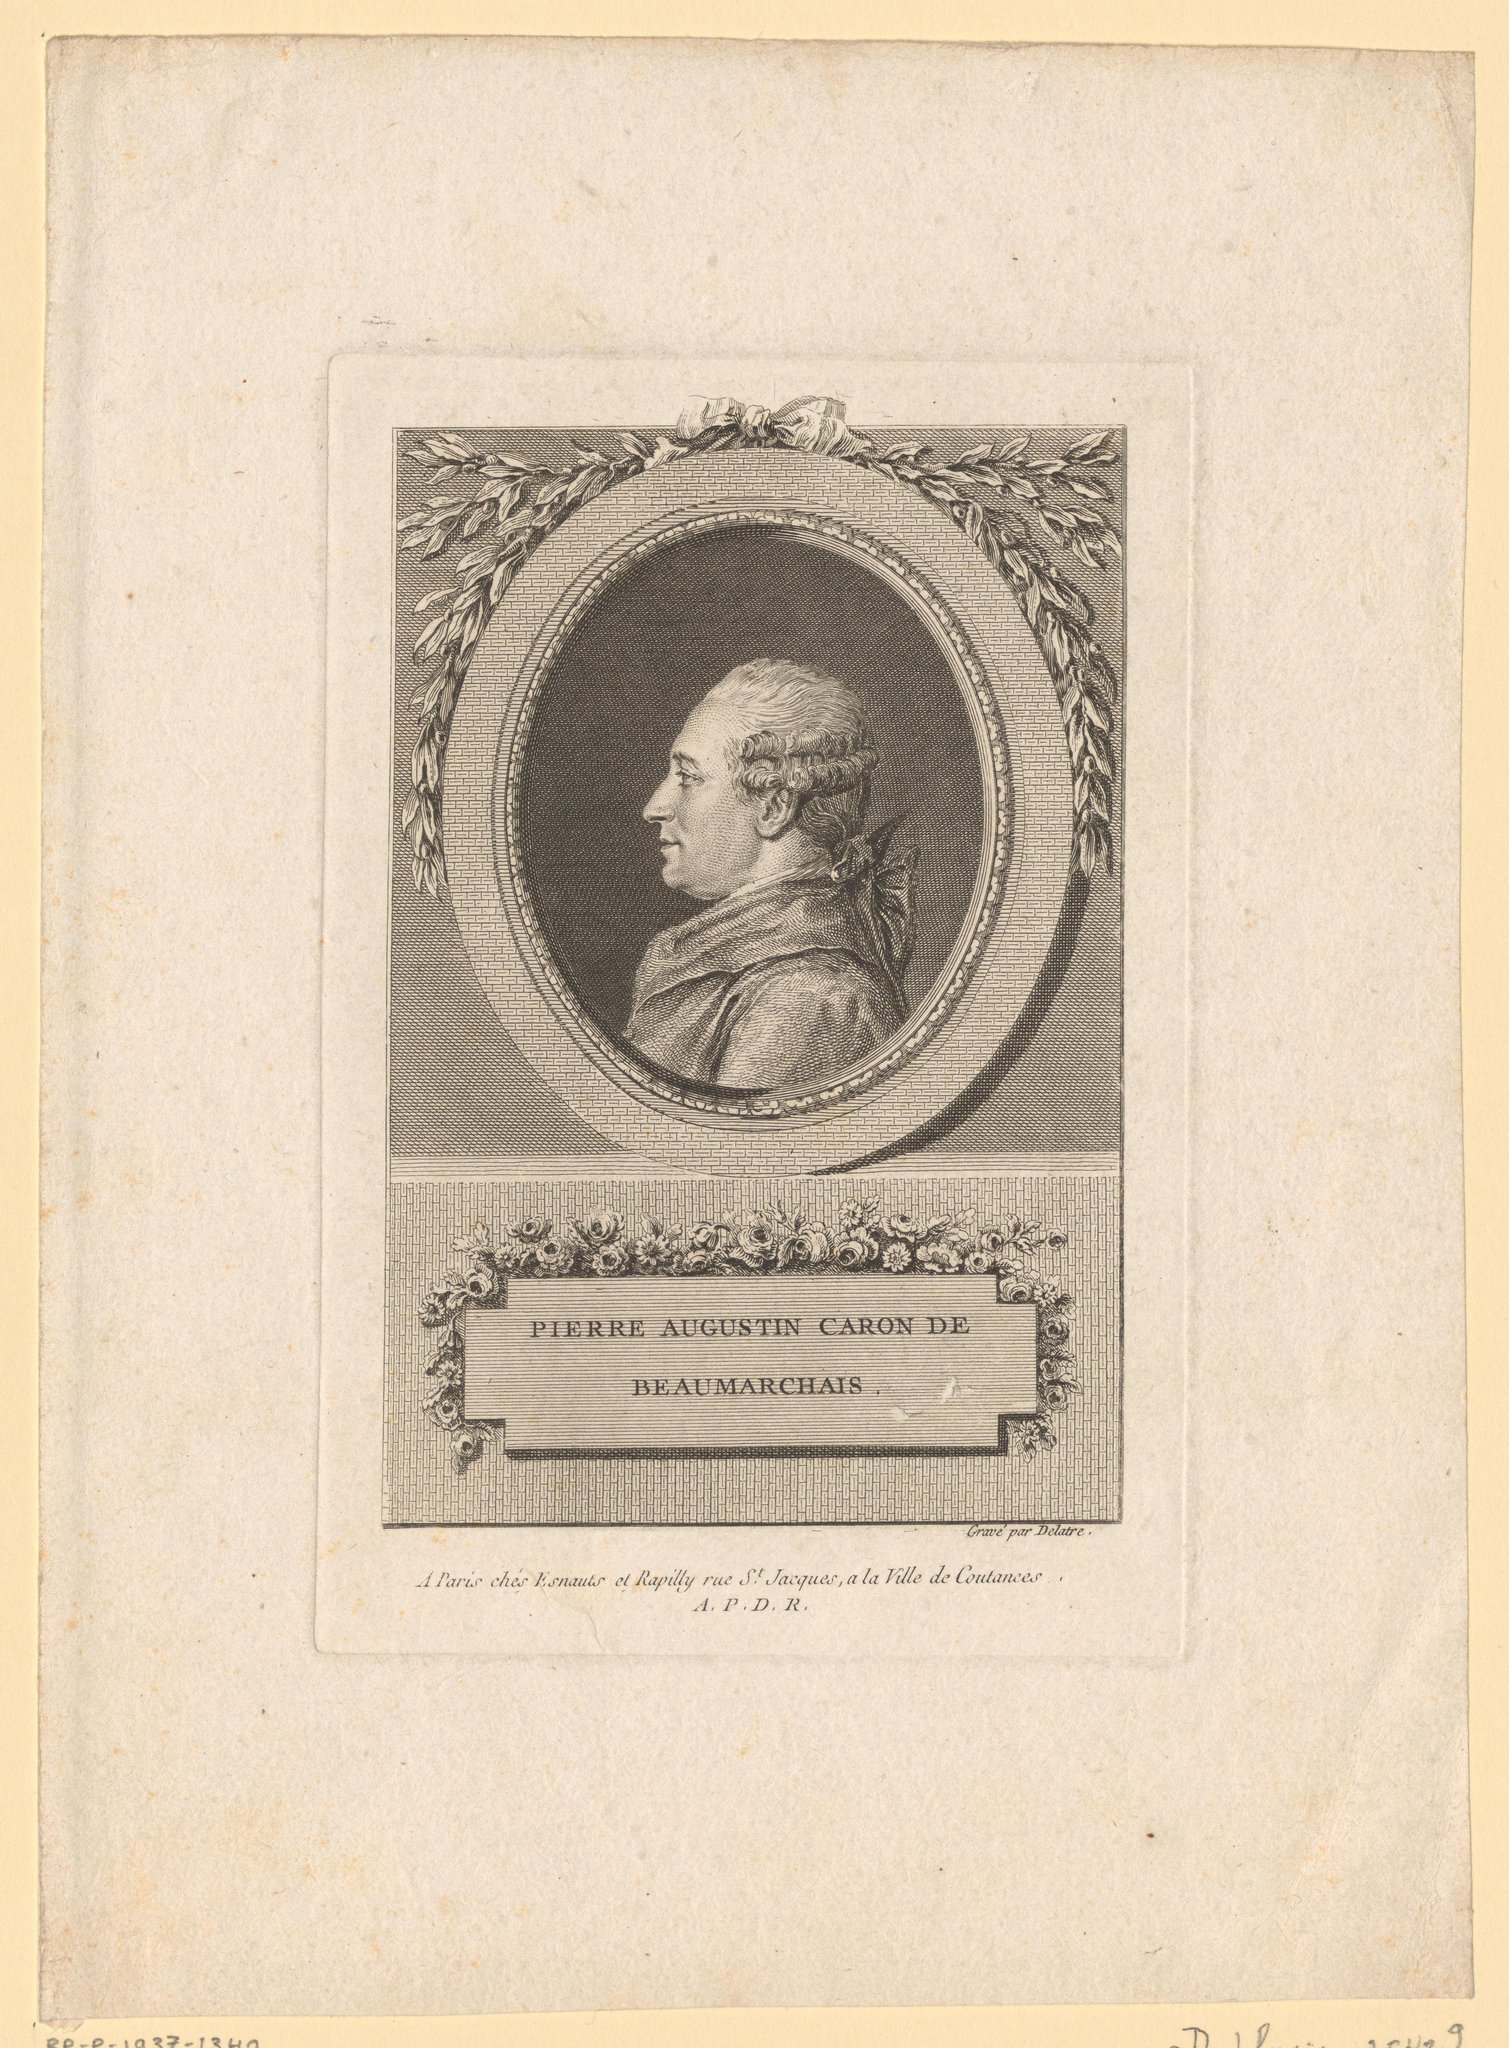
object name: print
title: Portret van Pierre Beaumarchais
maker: jean-marie delattre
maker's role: print maker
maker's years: 1745-1840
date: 1766-1804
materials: paper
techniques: etching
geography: paris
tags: paris, publisher, historical persons, portrait of a writer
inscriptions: collector's mark: Lugt 2228